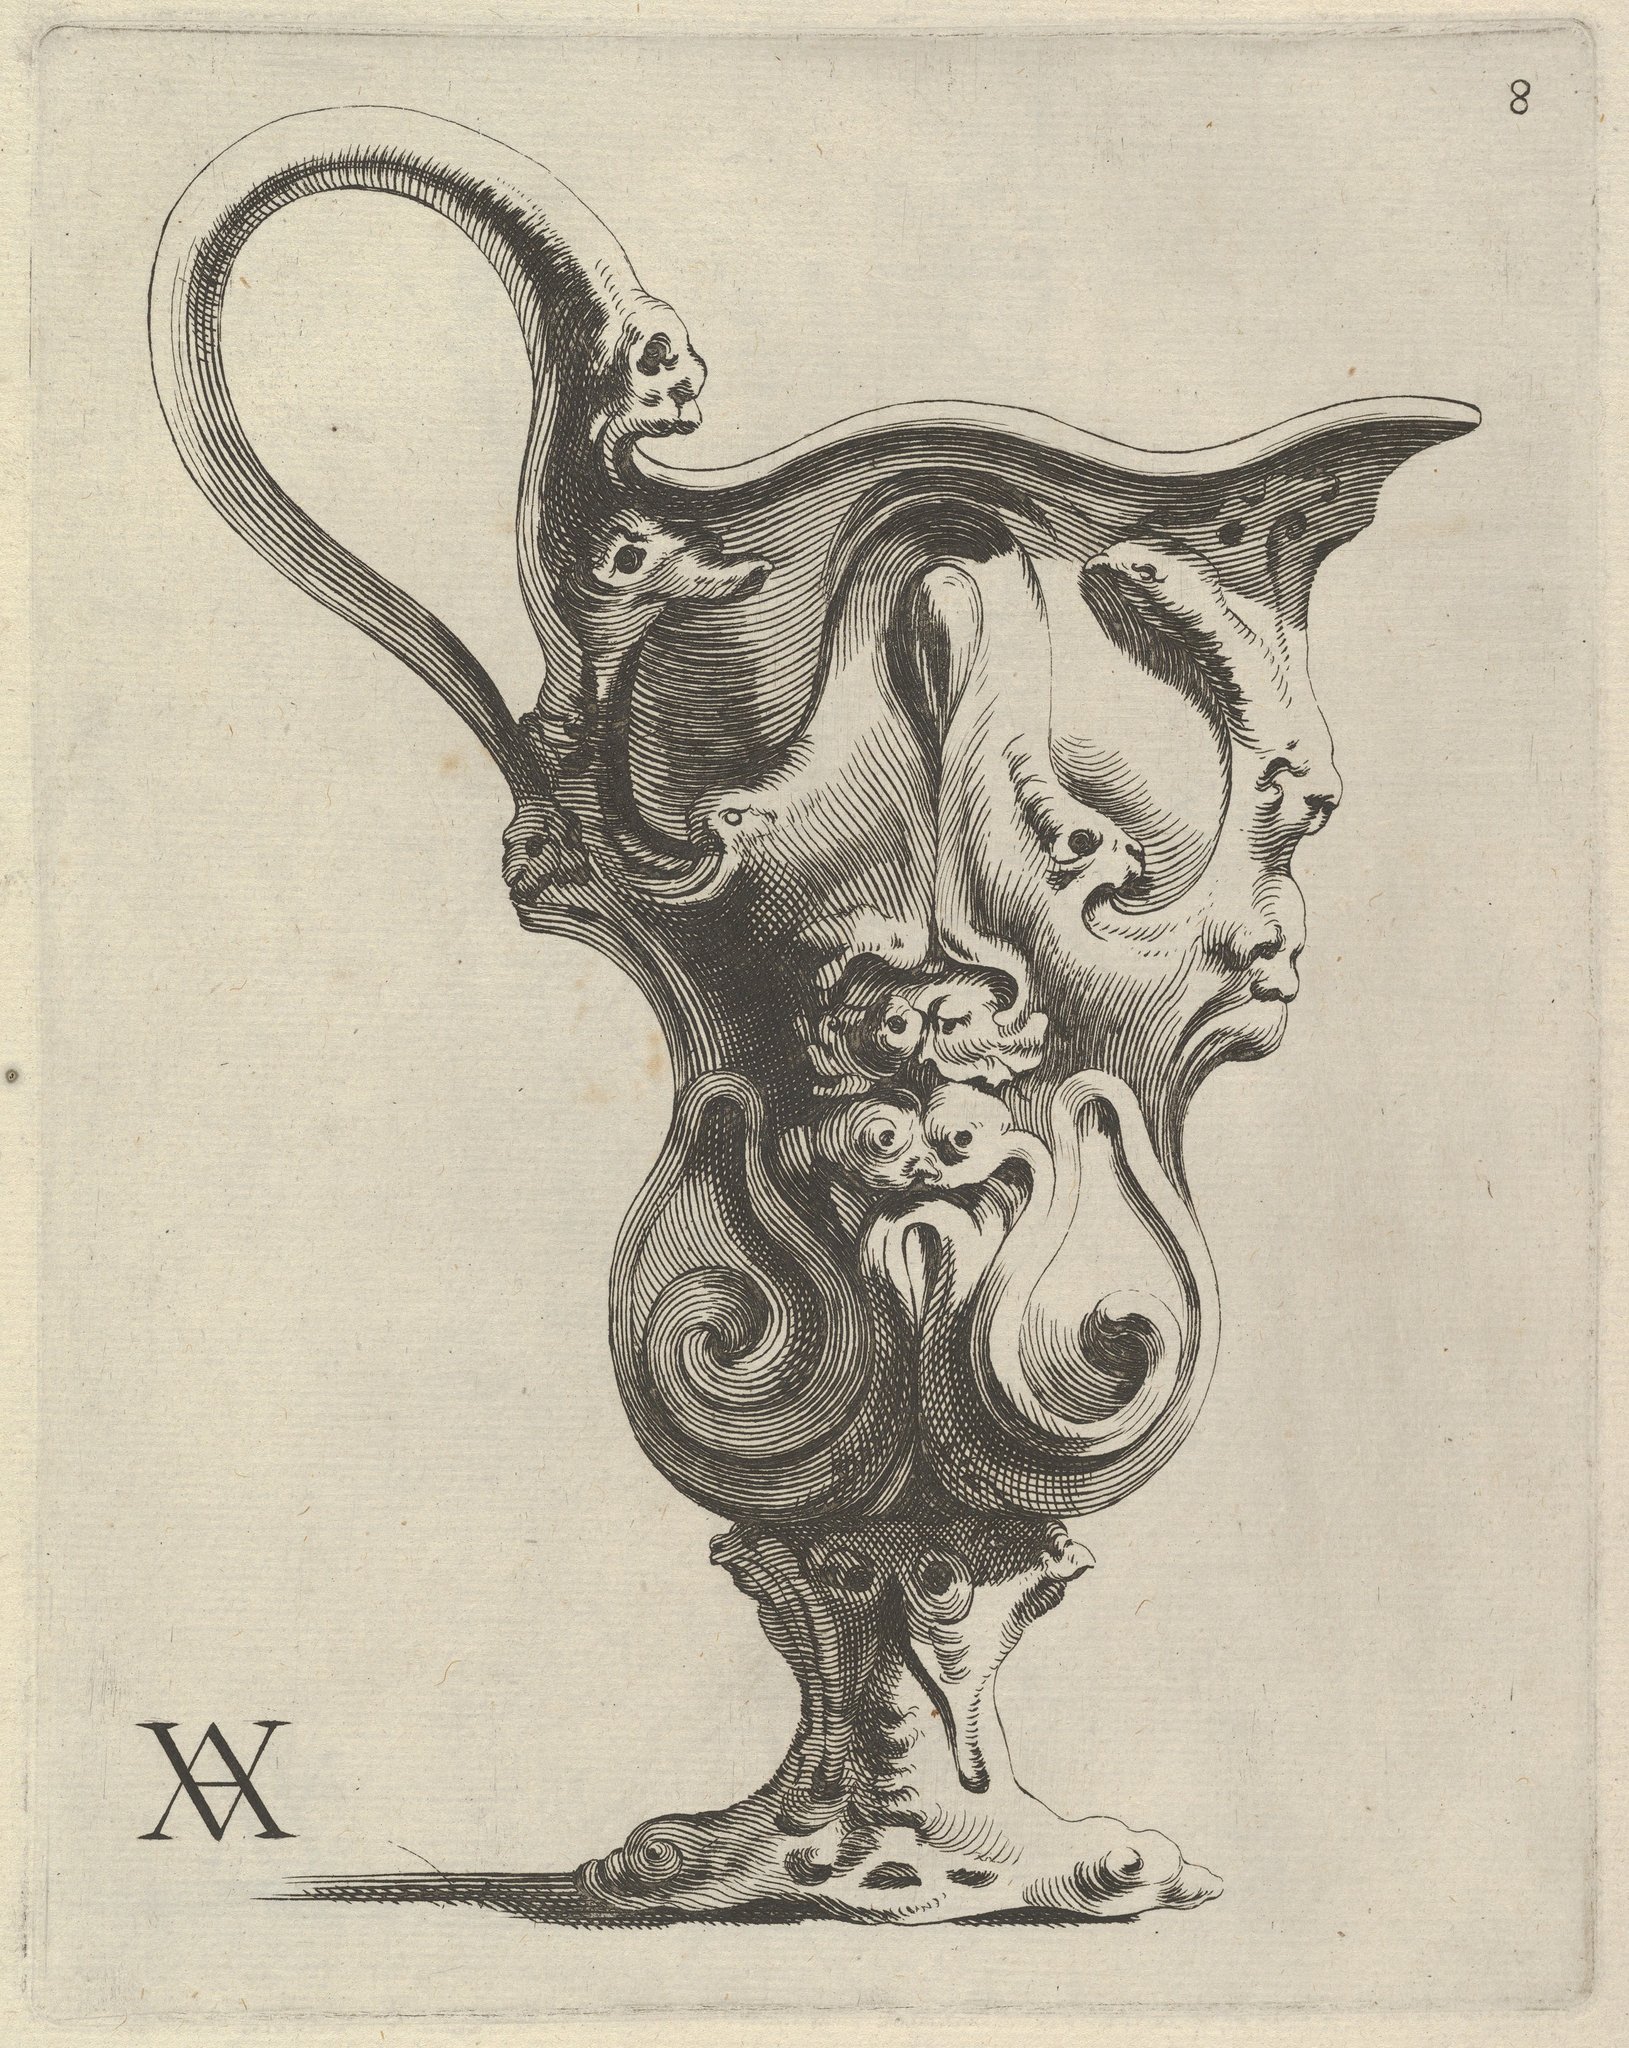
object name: album print ornament architecture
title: Plate 8, from "Modelli Artificiosi di Vasi diversi d'argento et altre Opere capriciozi (...), Parte prima"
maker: theodor van kessel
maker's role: artist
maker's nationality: dutch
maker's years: 1620-1660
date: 1646-1652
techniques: etching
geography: netherlands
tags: ornament